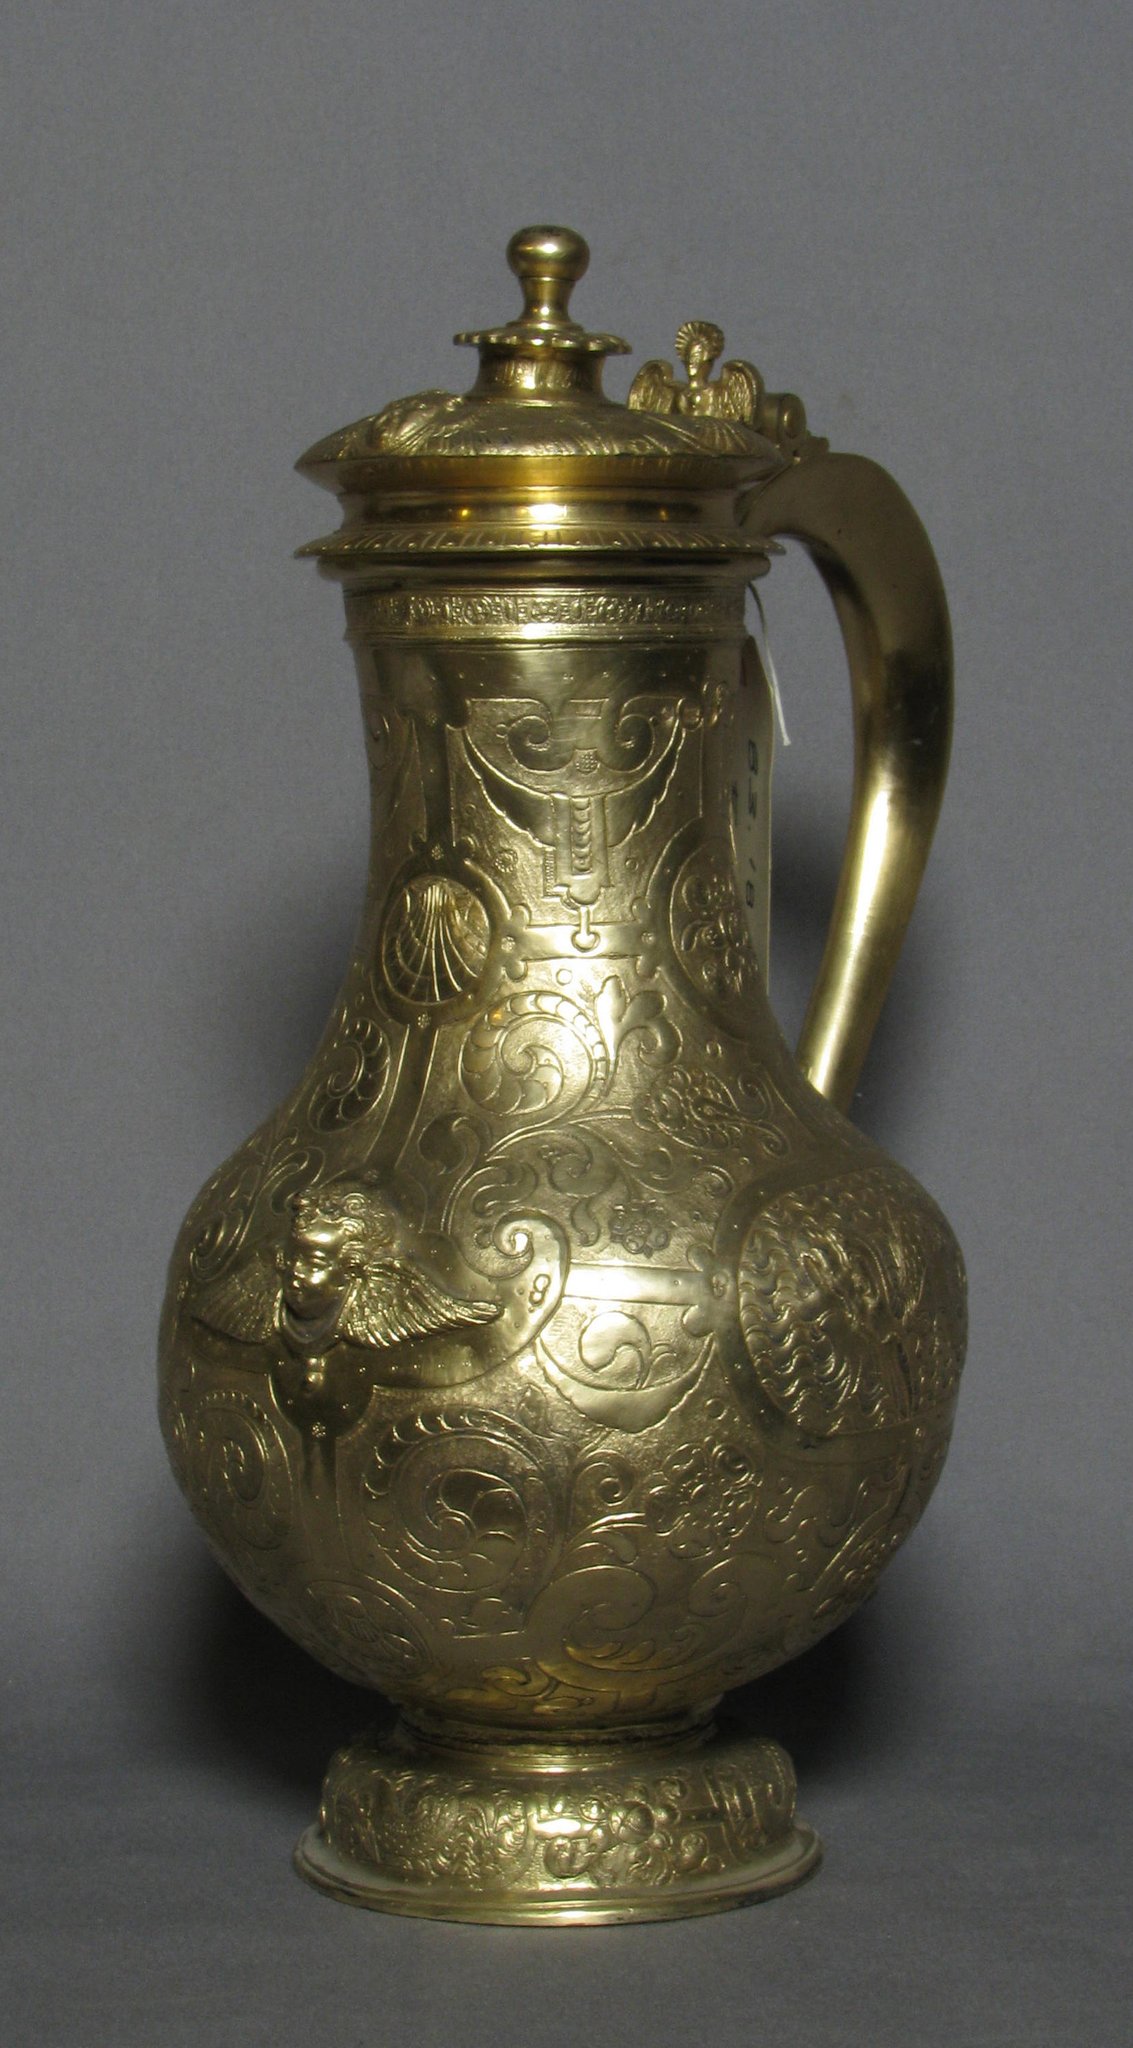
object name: flagon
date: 1801-1900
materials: metal, silver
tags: faces